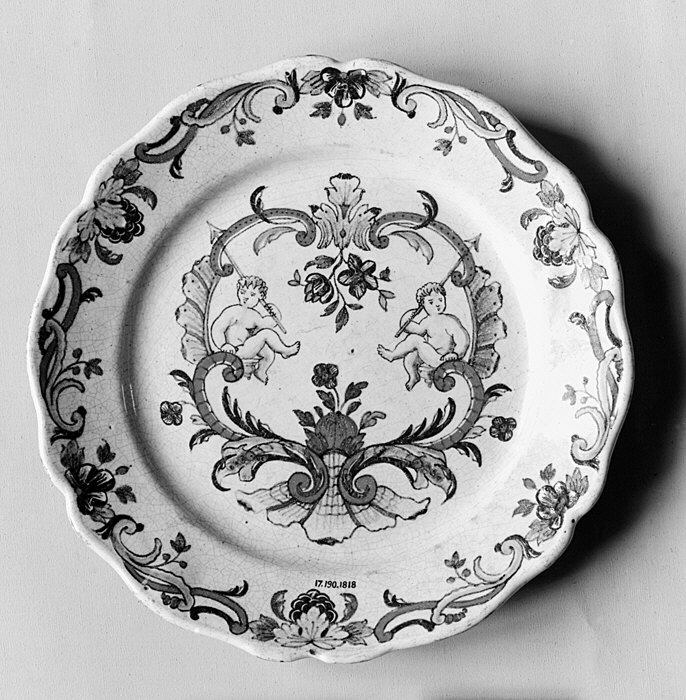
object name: plate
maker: pierre-clement caussey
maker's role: factory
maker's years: 1742-1782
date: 1750-1760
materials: faience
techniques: glazing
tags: cupid,flowers